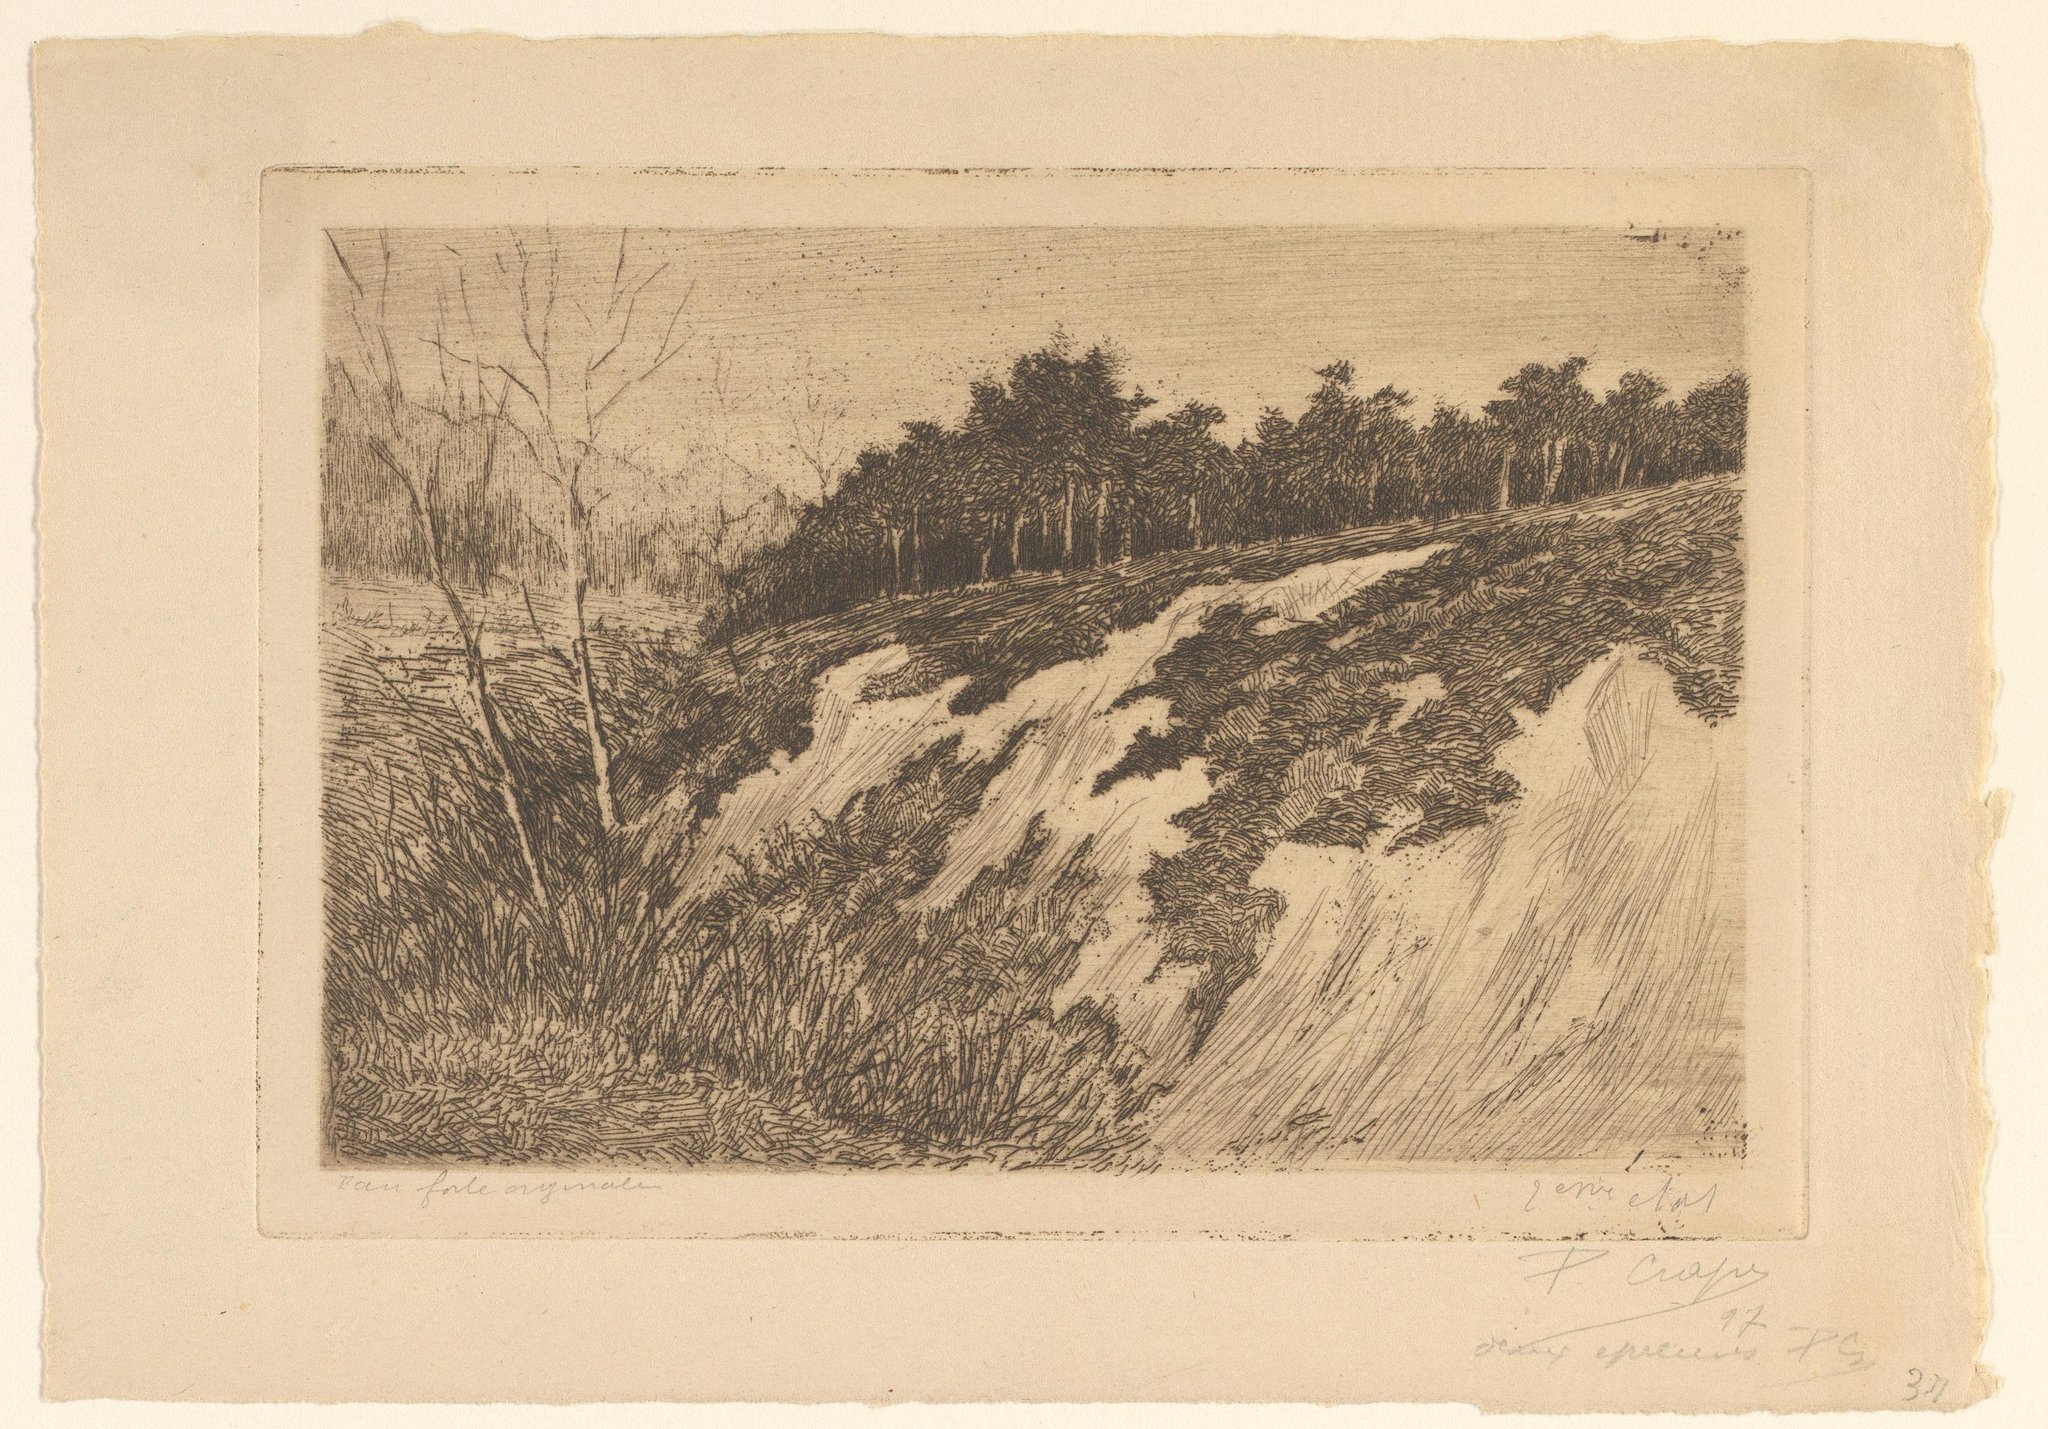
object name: print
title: Vue au Croeselberg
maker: pol craps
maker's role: print maker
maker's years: 1877-1939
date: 1897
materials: paper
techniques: drypoint, etching, intaglio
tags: clay and sand, etc. ~ building material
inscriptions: annotation: ‘eau-forte originale; 2eme etat; deux epreuves P.C.’, collector's mark: Lugt 2228